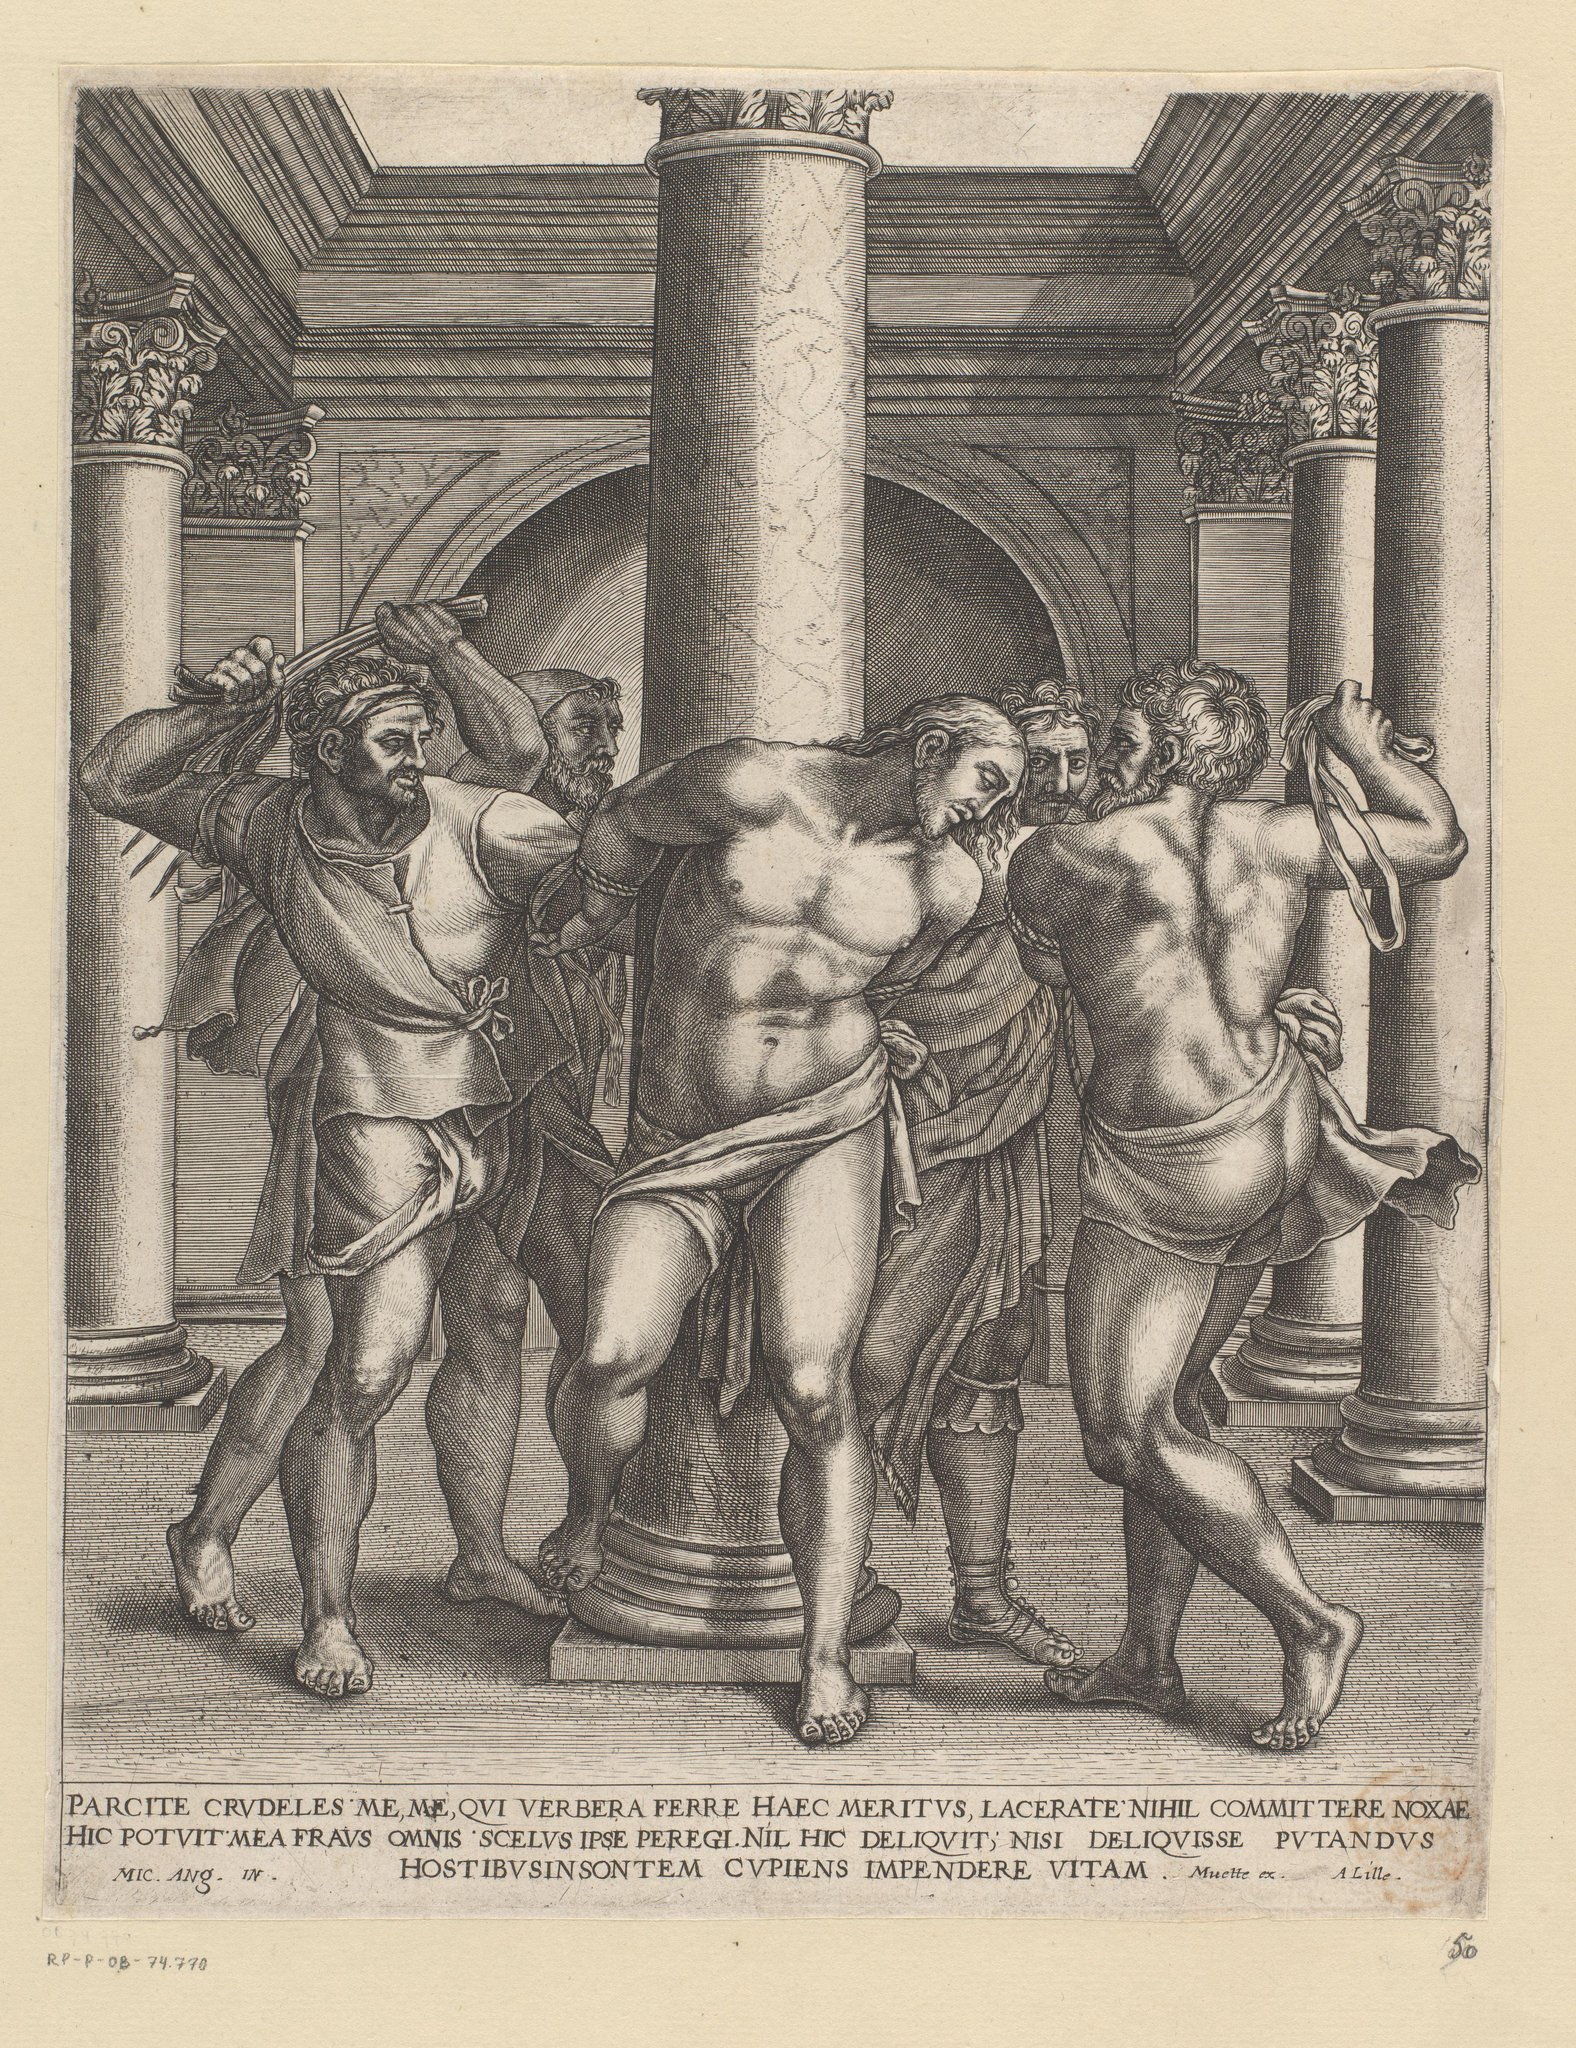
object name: print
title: Geseling van Christus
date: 1650-1700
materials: paper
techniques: engraving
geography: lille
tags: flagellation by soldiers, christ usually tied to a column (matthew 27:26; mark 15:15; john 19:1)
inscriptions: collector's mark: Lugt 240